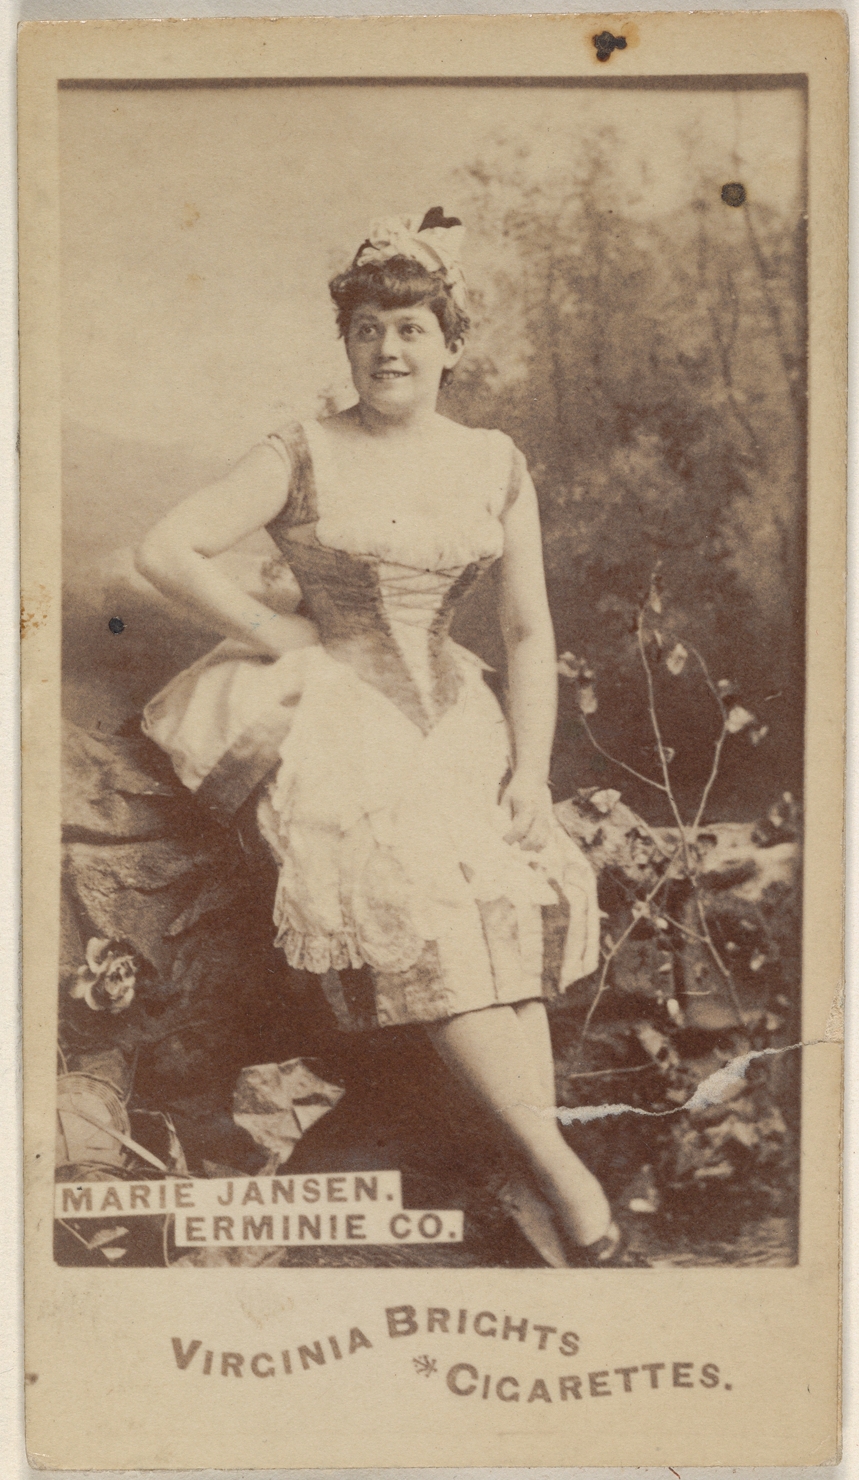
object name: photograph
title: Marie Jansen, Erminie Co., from the Actors and Actresses series (N45, Type 6) for Virginia Brights Cigarettes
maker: allen & ginter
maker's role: publisher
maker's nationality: american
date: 1888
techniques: albumen silver print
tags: portraits,women,actresses